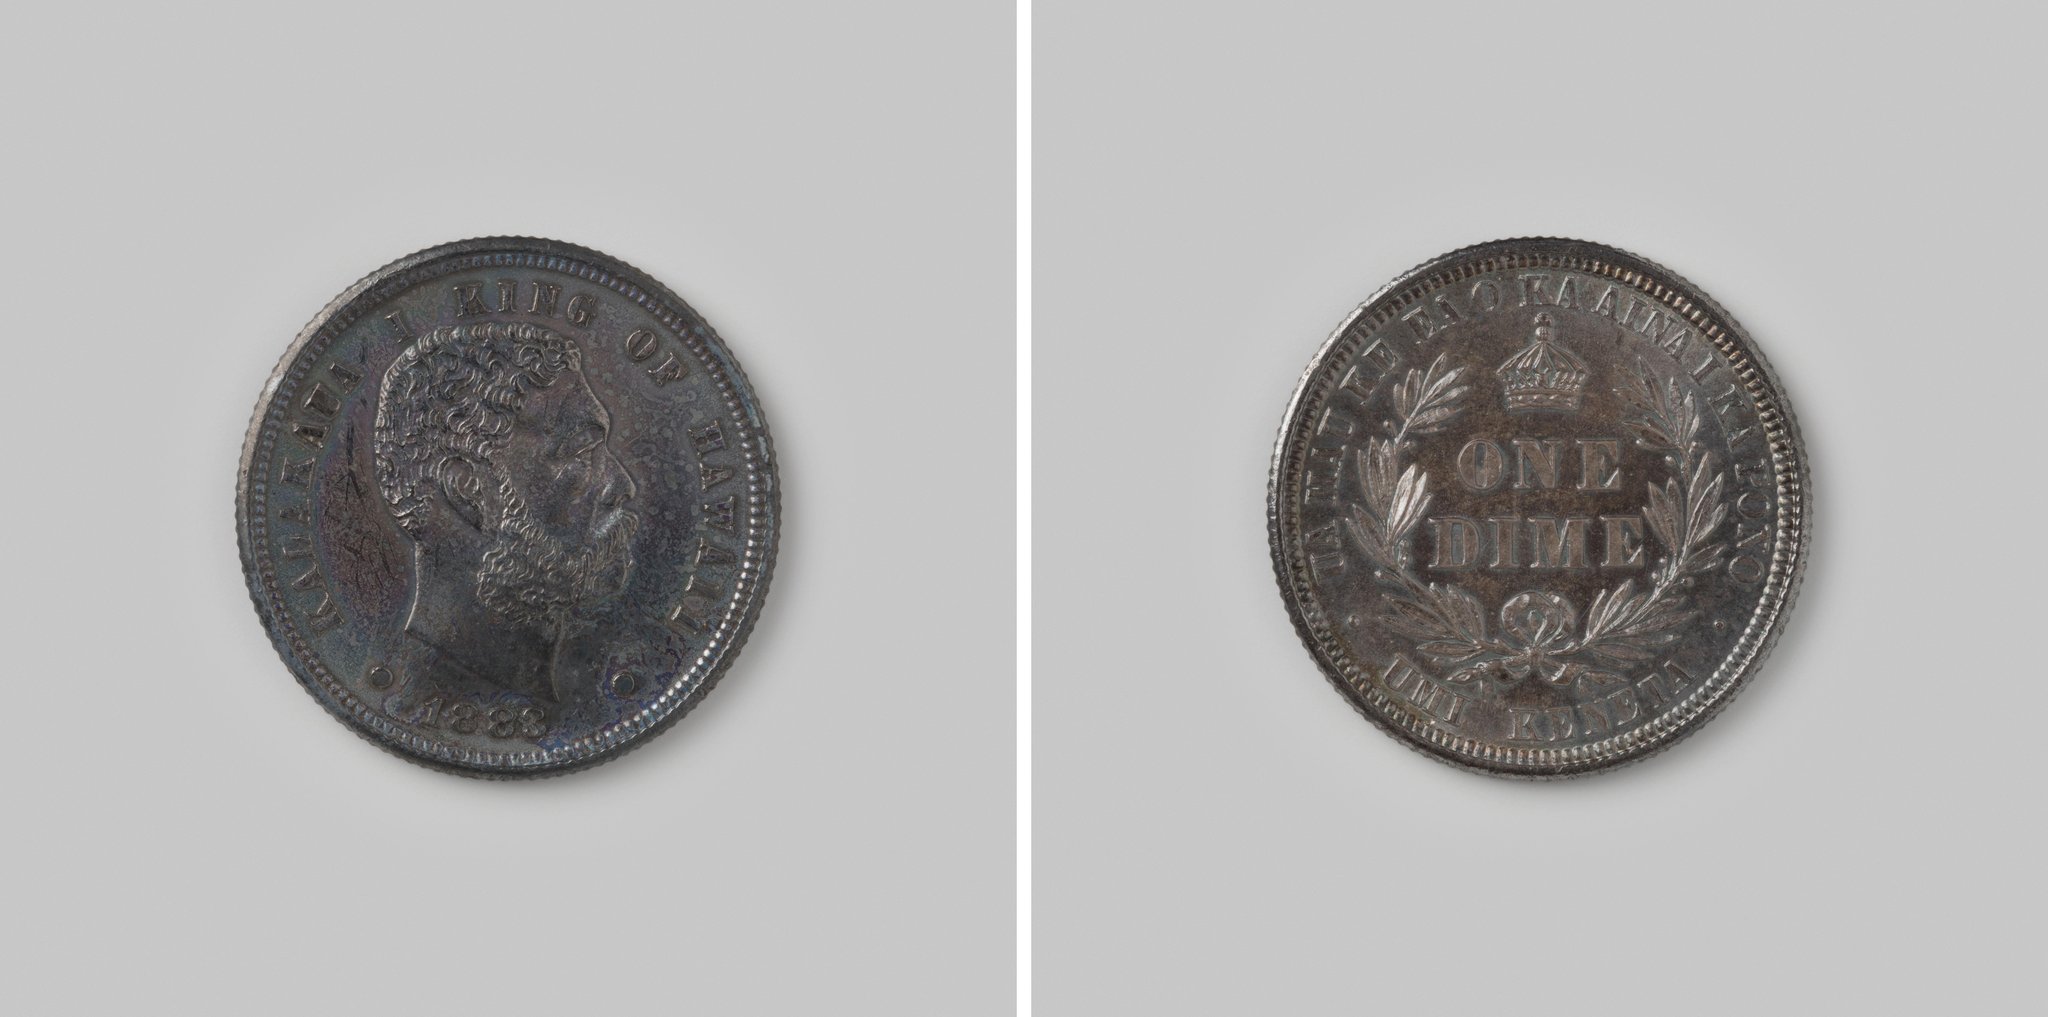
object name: coin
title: Dime [=1/10 dollar] of 10 kuneta uit Hawaii of Sandwichs eilanden van Kalakaoewa I, 1883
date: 1883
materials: silver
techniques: striking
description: Zilveren munt. Voorzijde: hoofd van de konnig naar rechts. Jaartal onderaan. Keerzijde: tussen twee samengebonden takken kroon, waaronder waarde-aanduiding: one dime in twee regels. Onderaan waarde-aanduiding: 10 kuneta. Gladde rand.